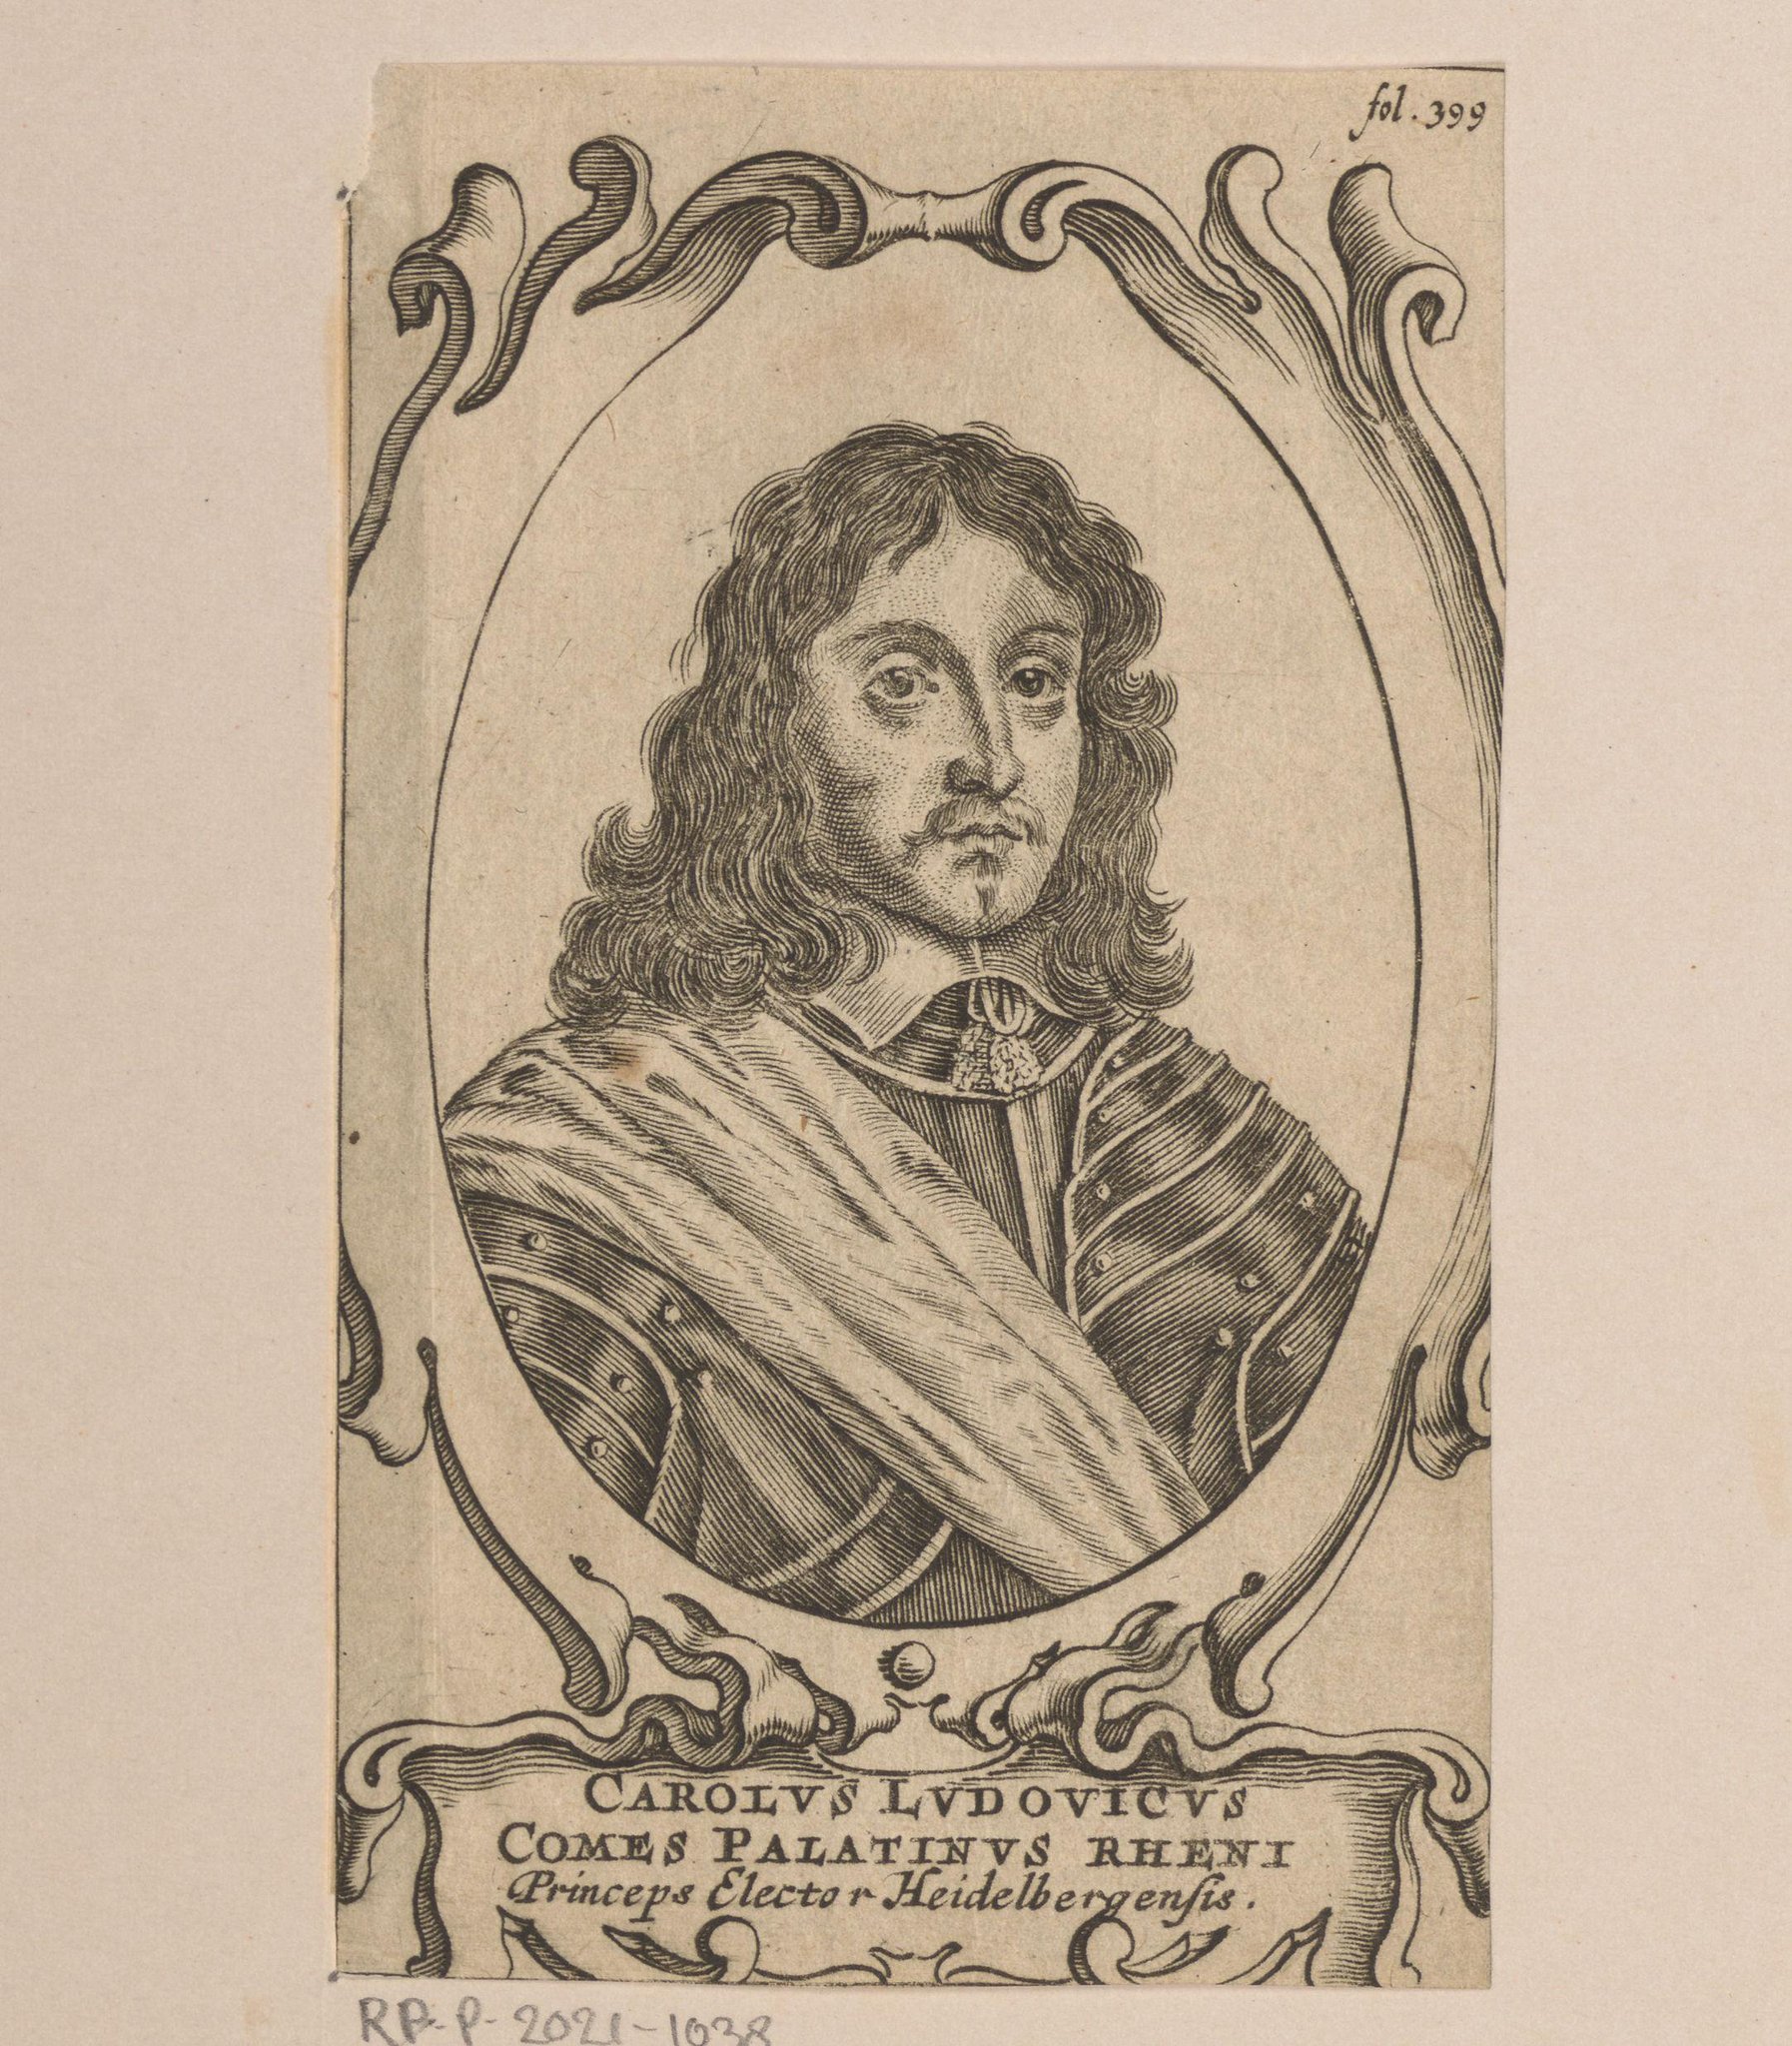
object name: print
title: Portret van Karel Lodewijk, keurvorst van de Palts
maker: Anonymous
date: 1656-1666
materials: paper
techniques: engraving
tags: historical persons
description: Prent mogelijk uit: Brachelius, Johannes Adolphus. Historia nostri temporis, dat is geschiedenis onses tijts (…). Rotterdam: Andries van Hoogenhuysen, 1656. Of uit een latere editie (1659, 1666).